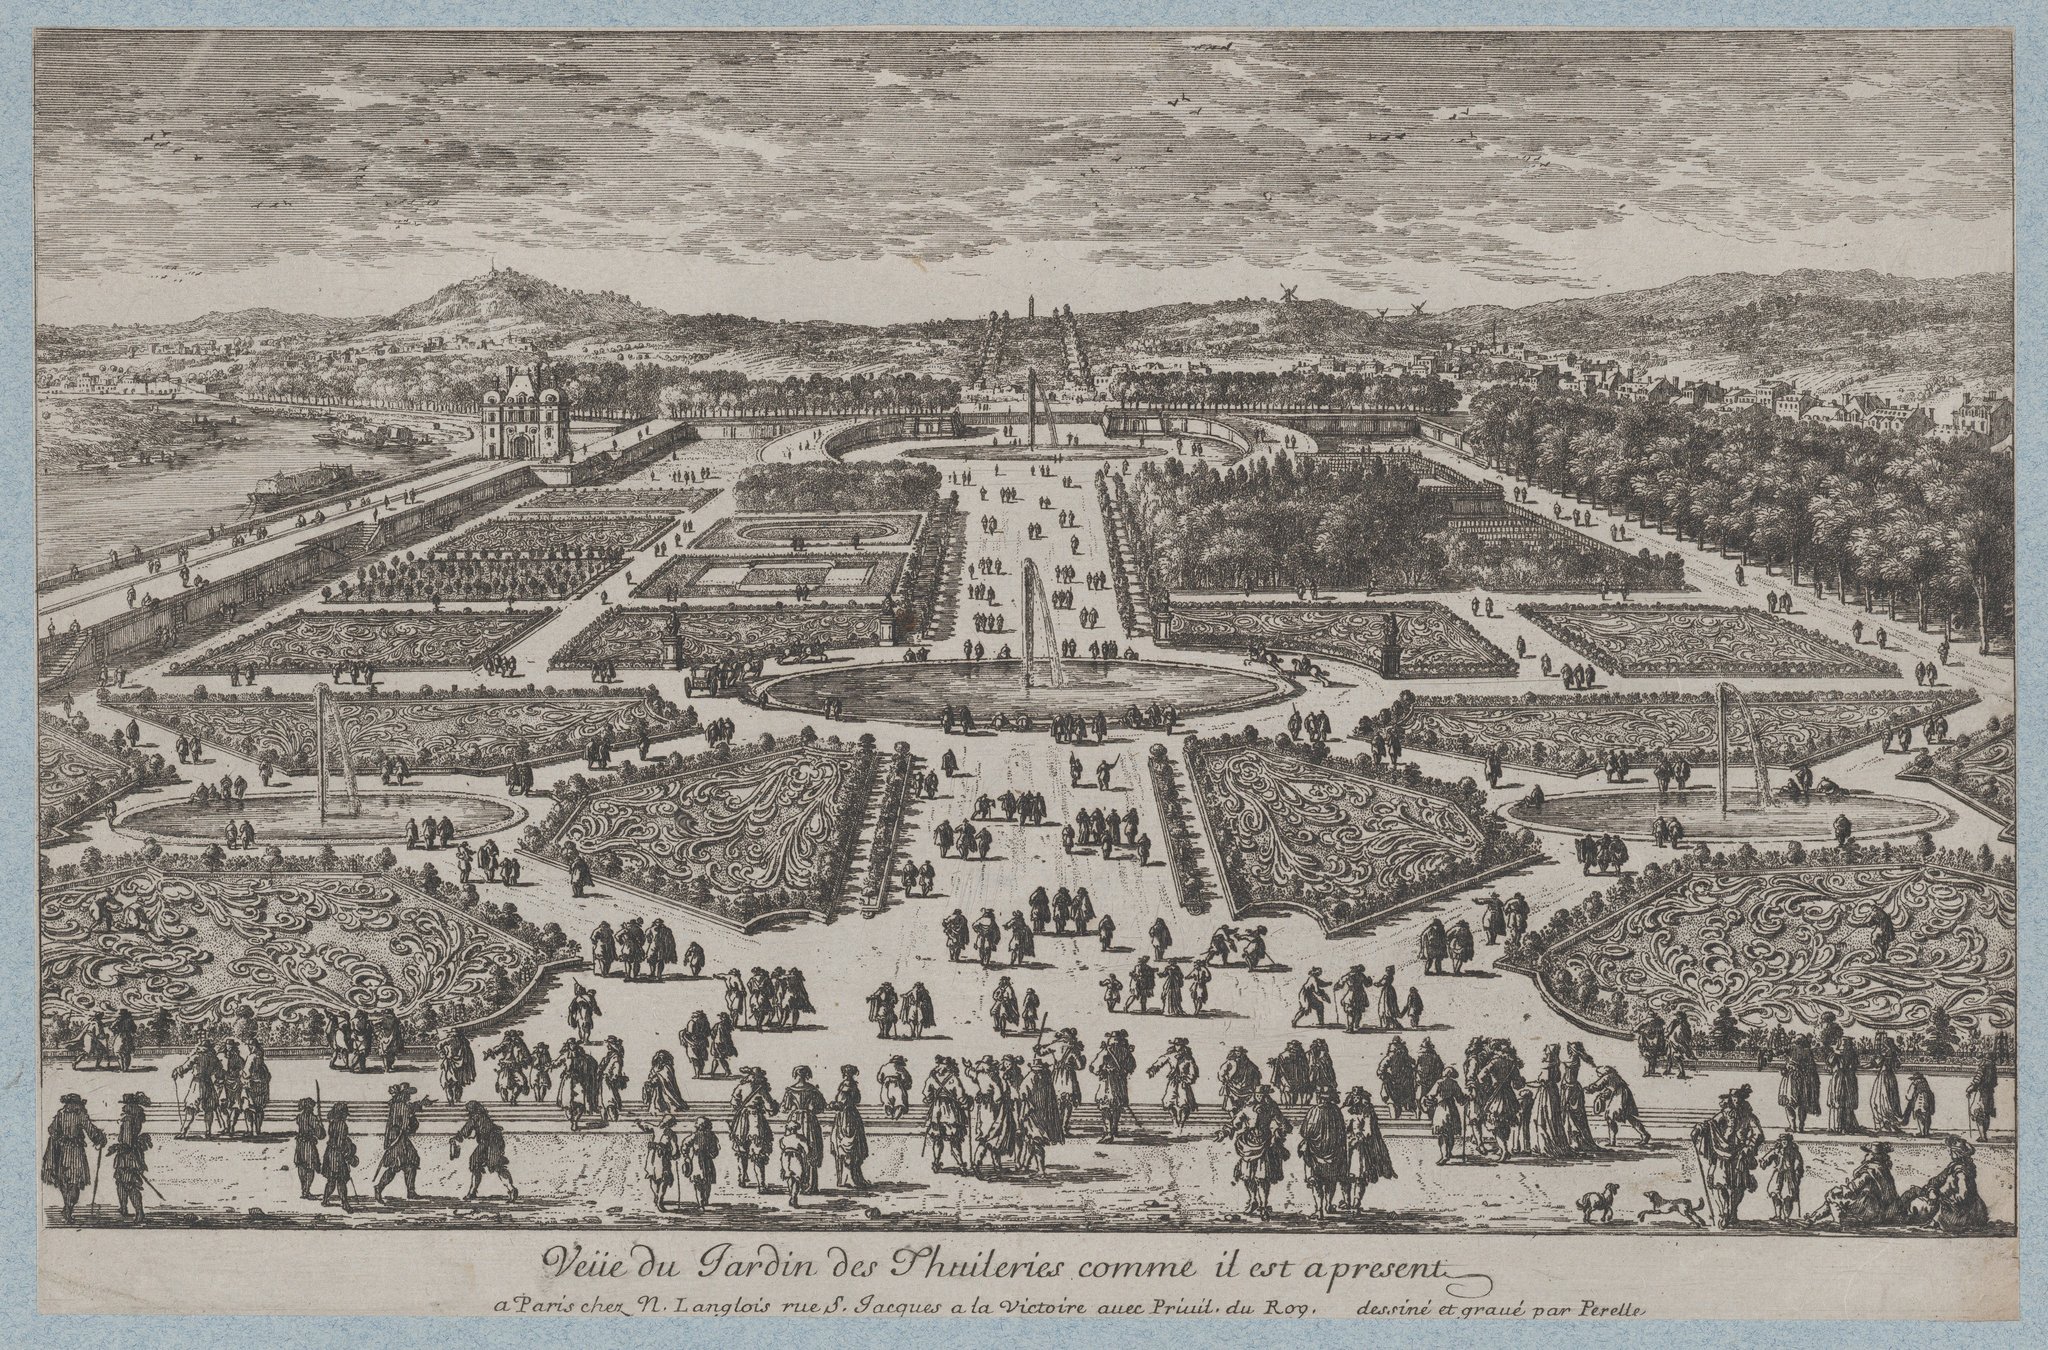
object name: print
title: The Tuileries Garden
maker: adam perelle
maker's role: artist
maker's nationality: french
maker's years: 1640-1695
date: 1680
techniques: etching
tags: gardens,crowd